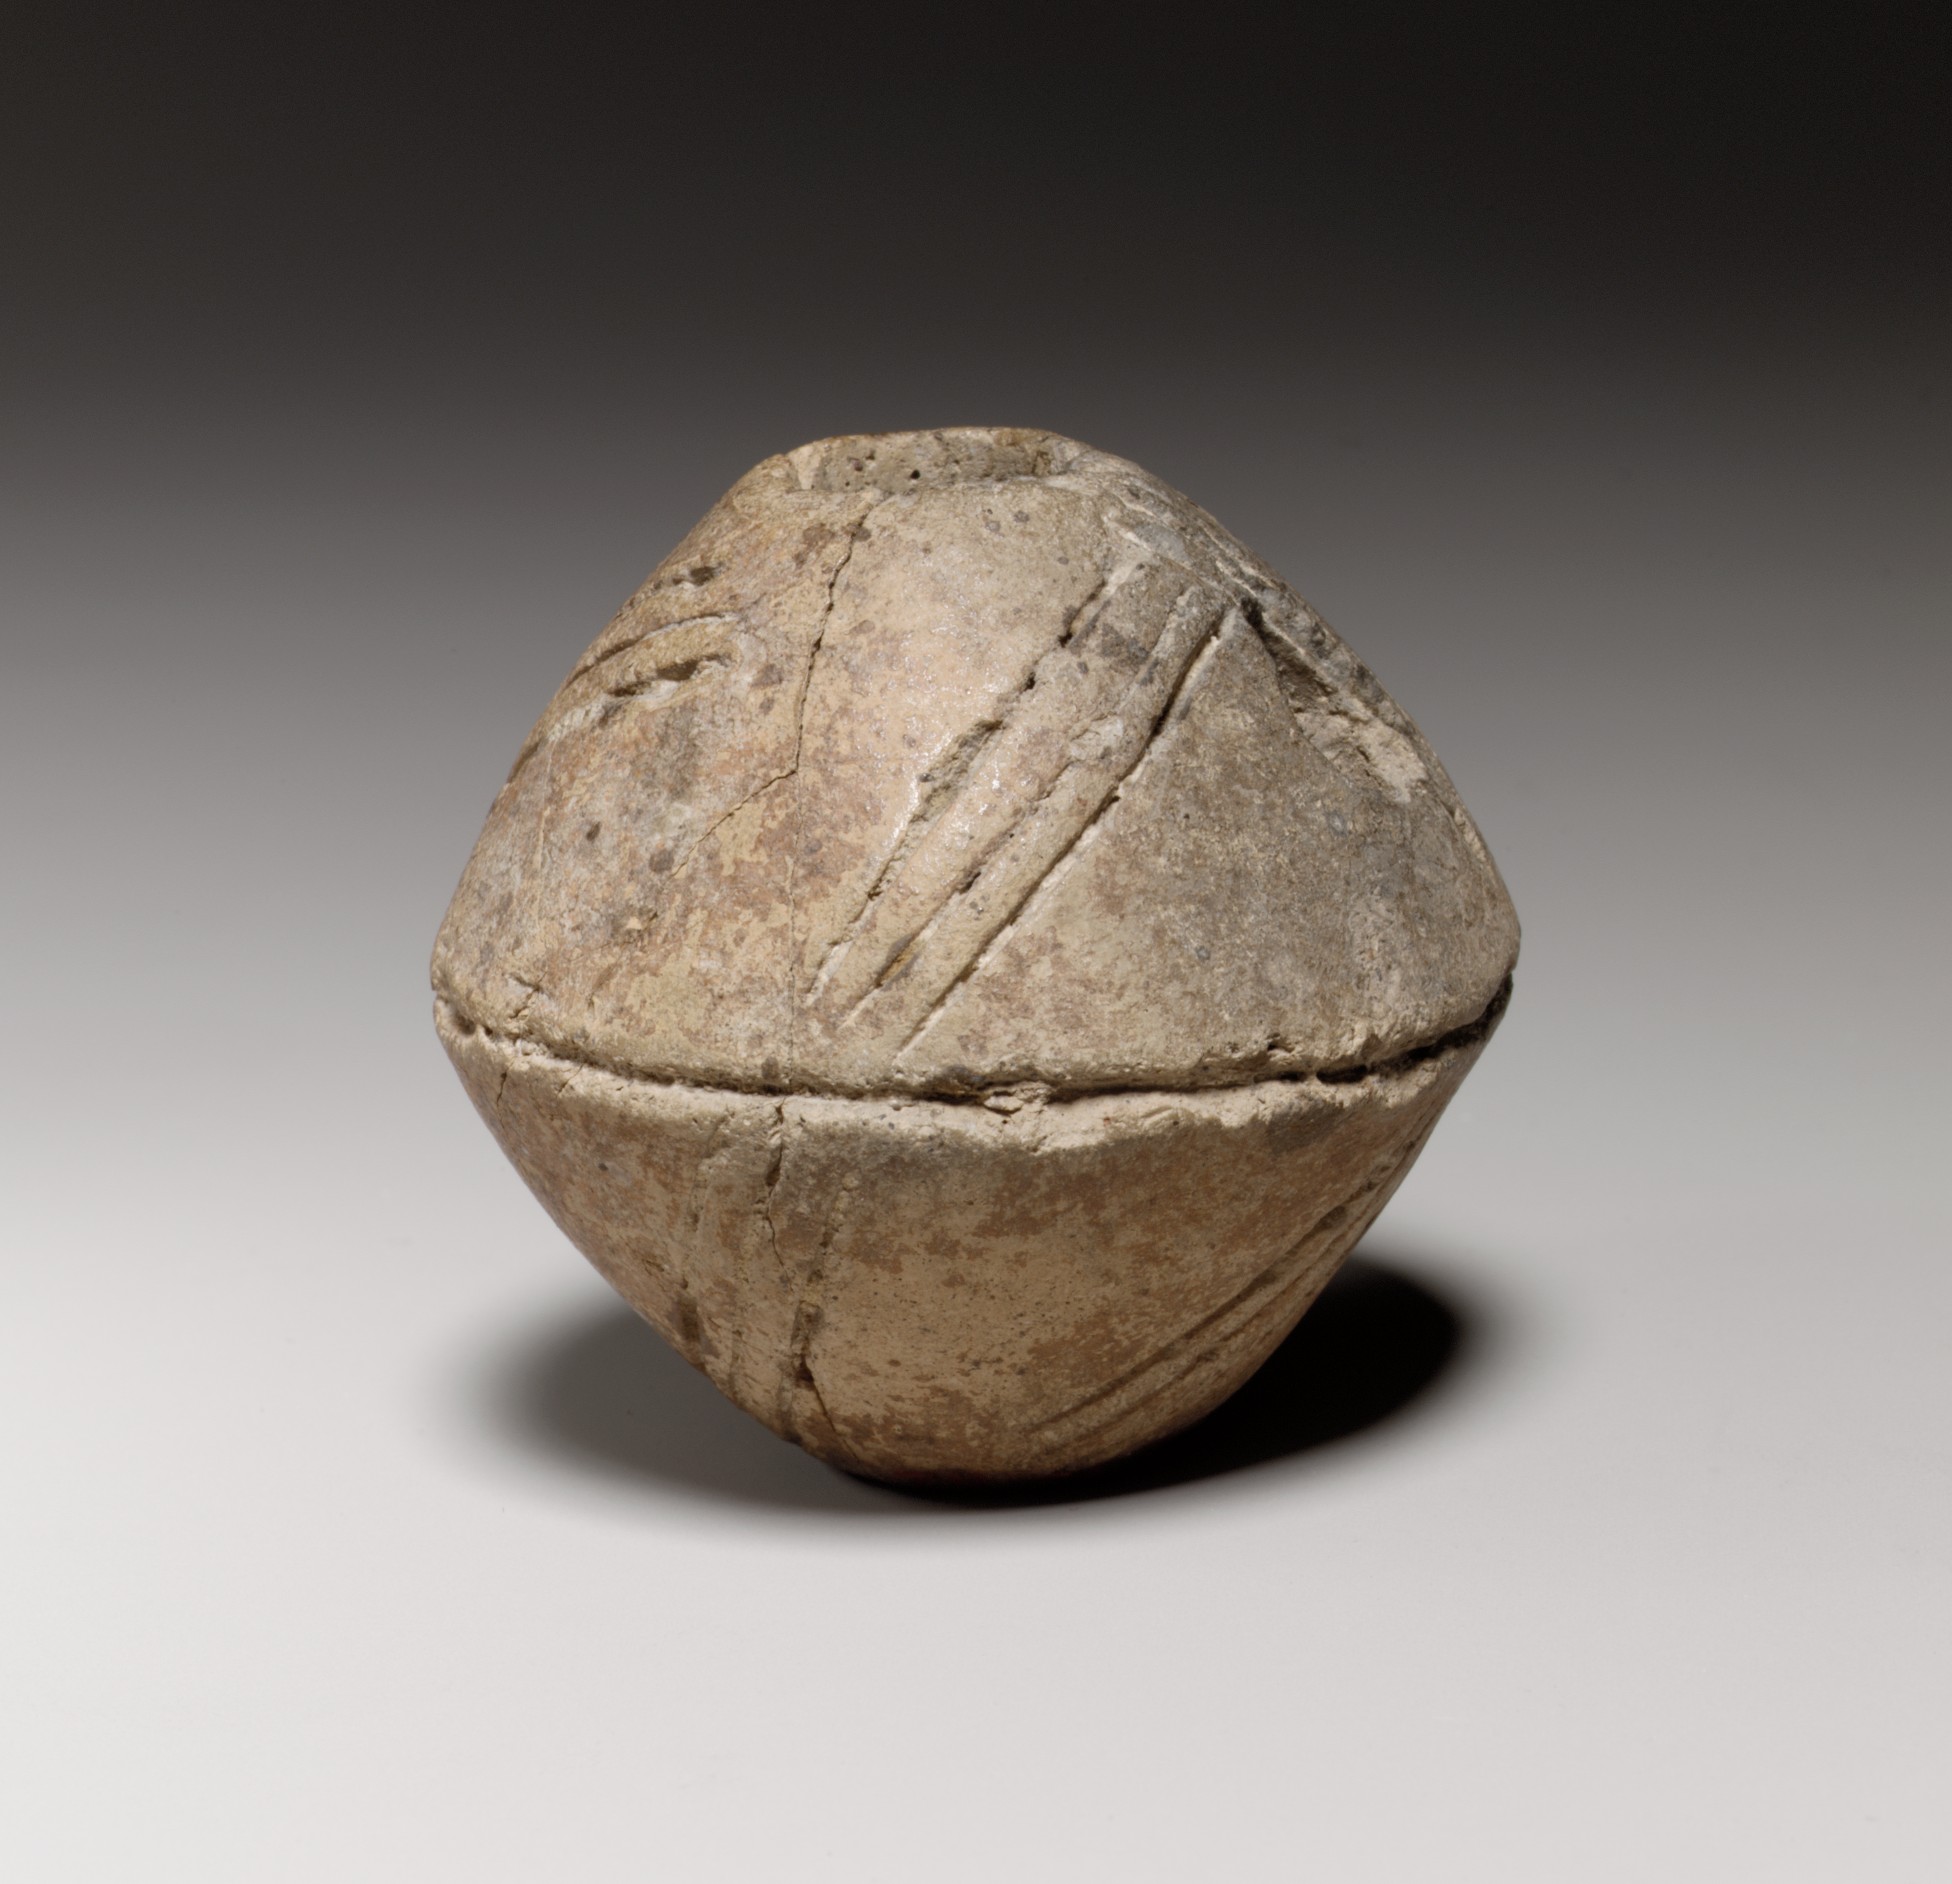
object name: spindle whorl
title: Terracotta biconical spindle-whorl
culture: cypriot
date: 1600-1200 BCE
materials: terracotta